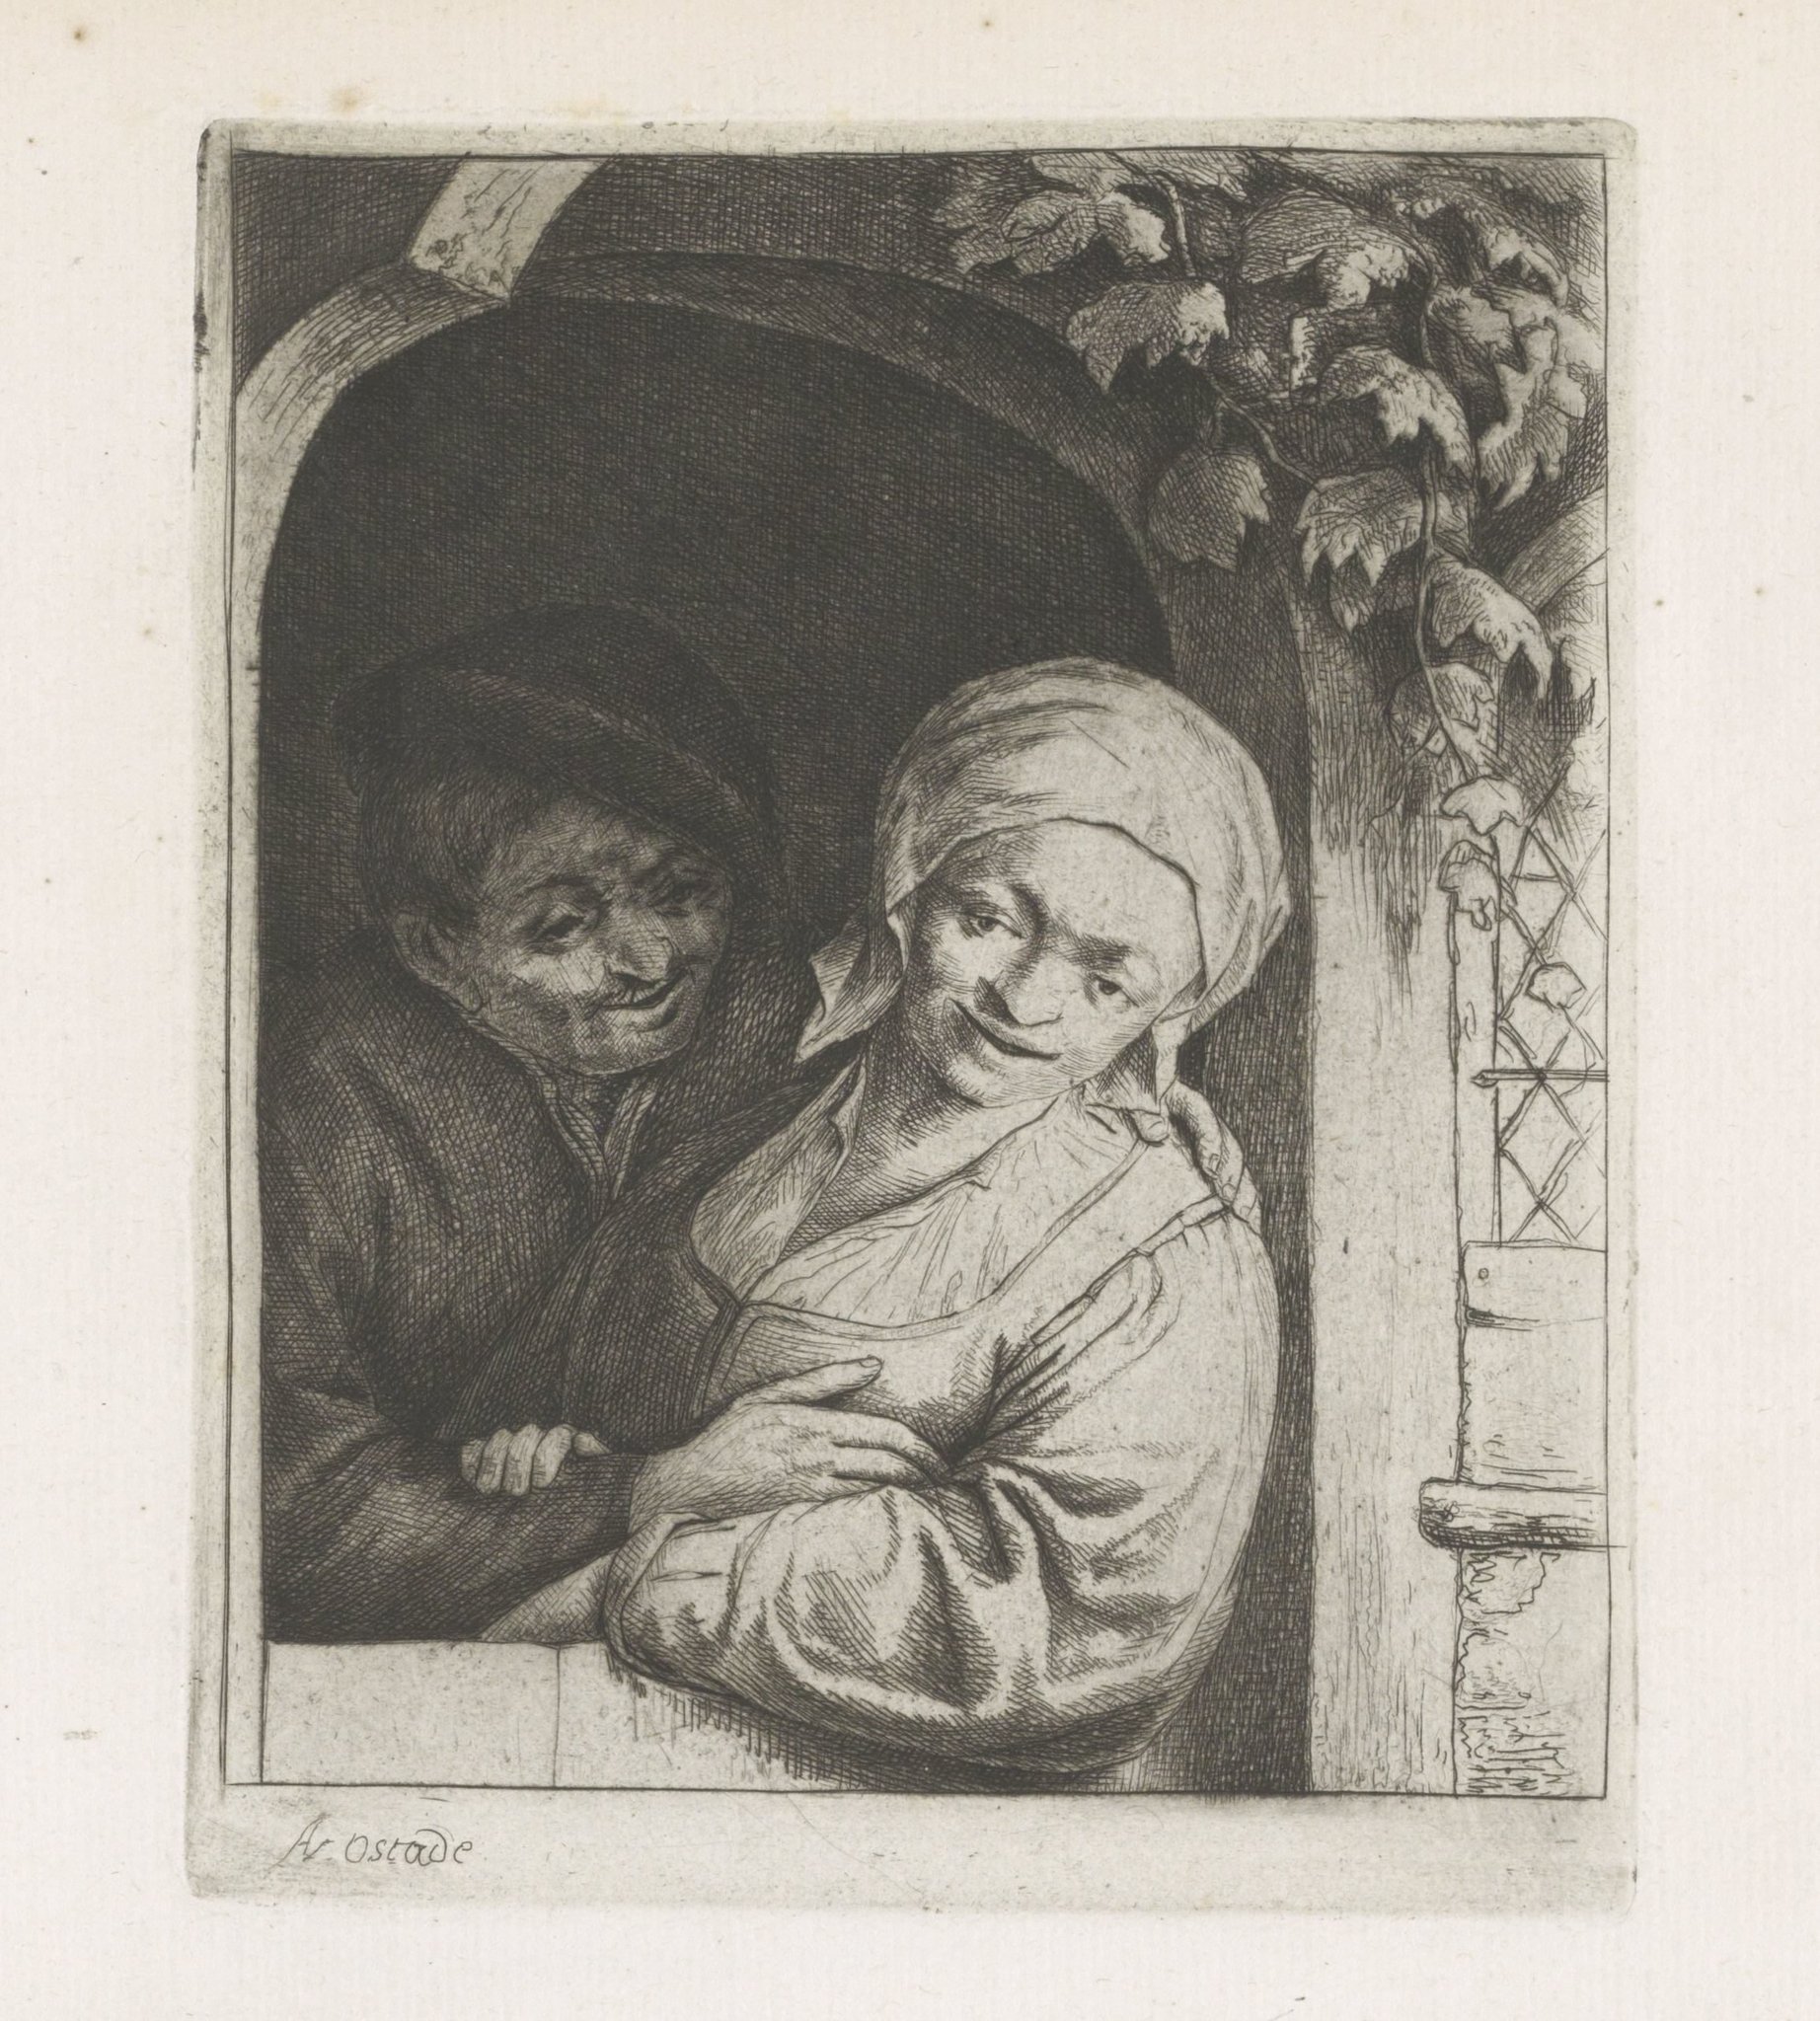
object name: album leaf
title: Boer en boerin als liefdespaar in deuropening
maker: adriaen van ostade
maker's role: draughtsman, painter, print maker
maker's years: 1610-1685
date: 1650-1654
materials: paper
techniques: etching, intaglio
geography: haarlem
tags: farmers, divided door, upper part opened, couple of lovers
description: Deze prent maakt deel uit van een album.